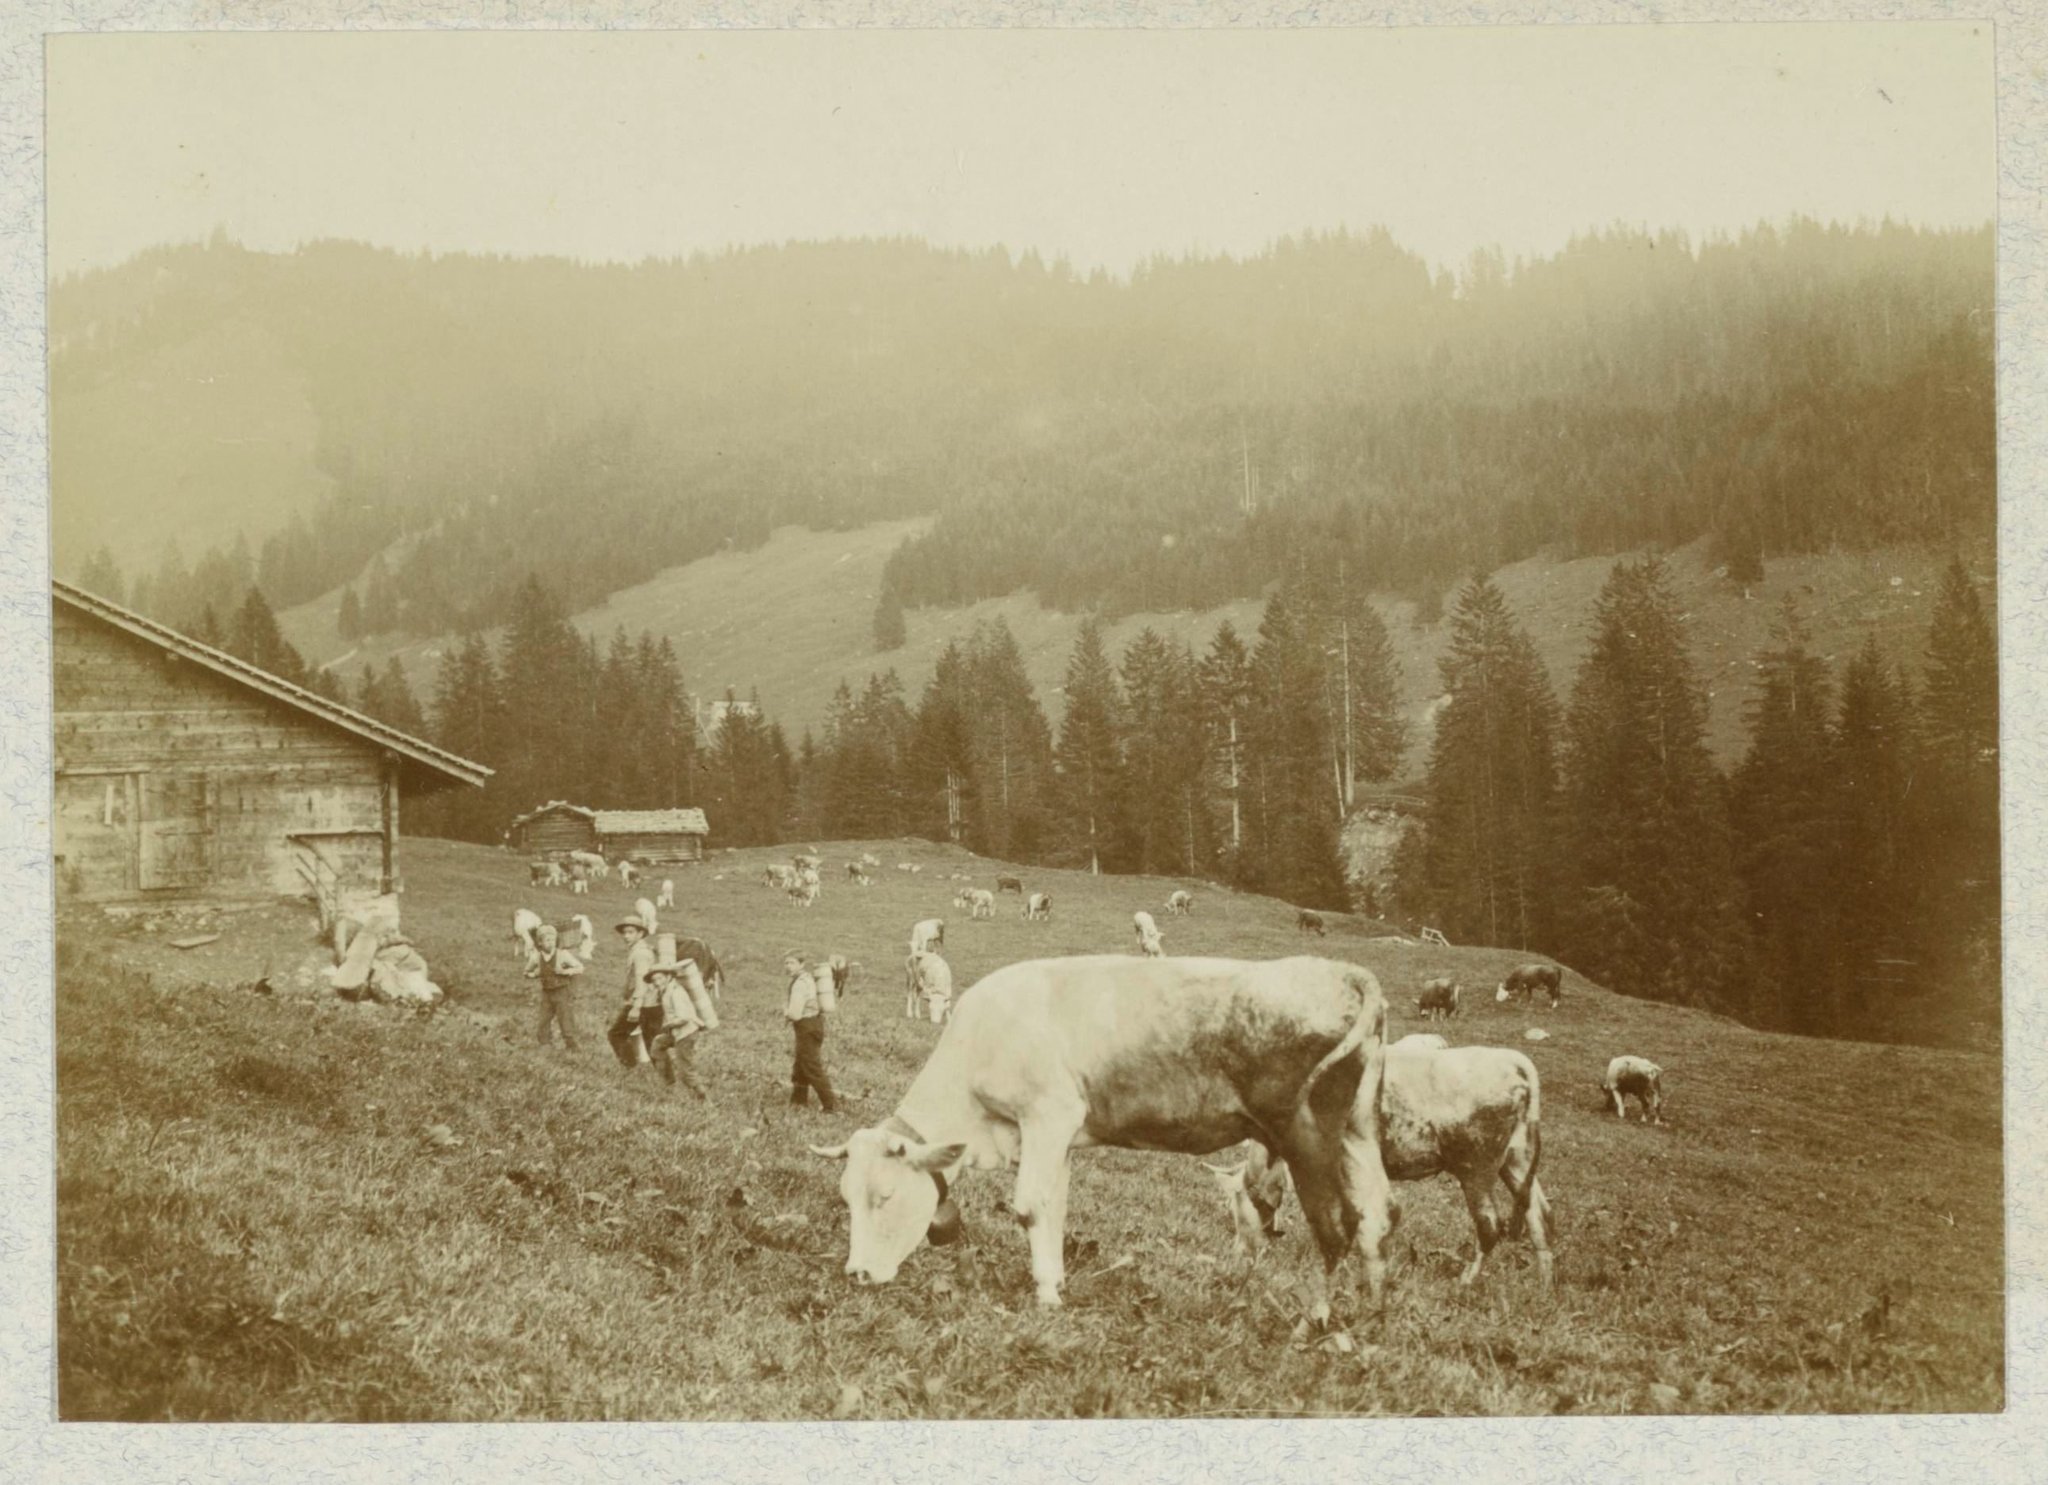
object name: photograph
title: Vakantie in Zwitserland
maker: andries augustus boom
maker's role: amateurfotograaf, handelaar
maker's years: 1878-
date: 1805-1899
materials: photographic support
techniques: photography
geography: switzerland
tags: andries augustus boom, switzerland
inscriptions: date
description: Vakantie in Zwitserland. Onderdeel van het fotoalbum van de familie Boom-Gonggrijp in Suriname en Curaçao.